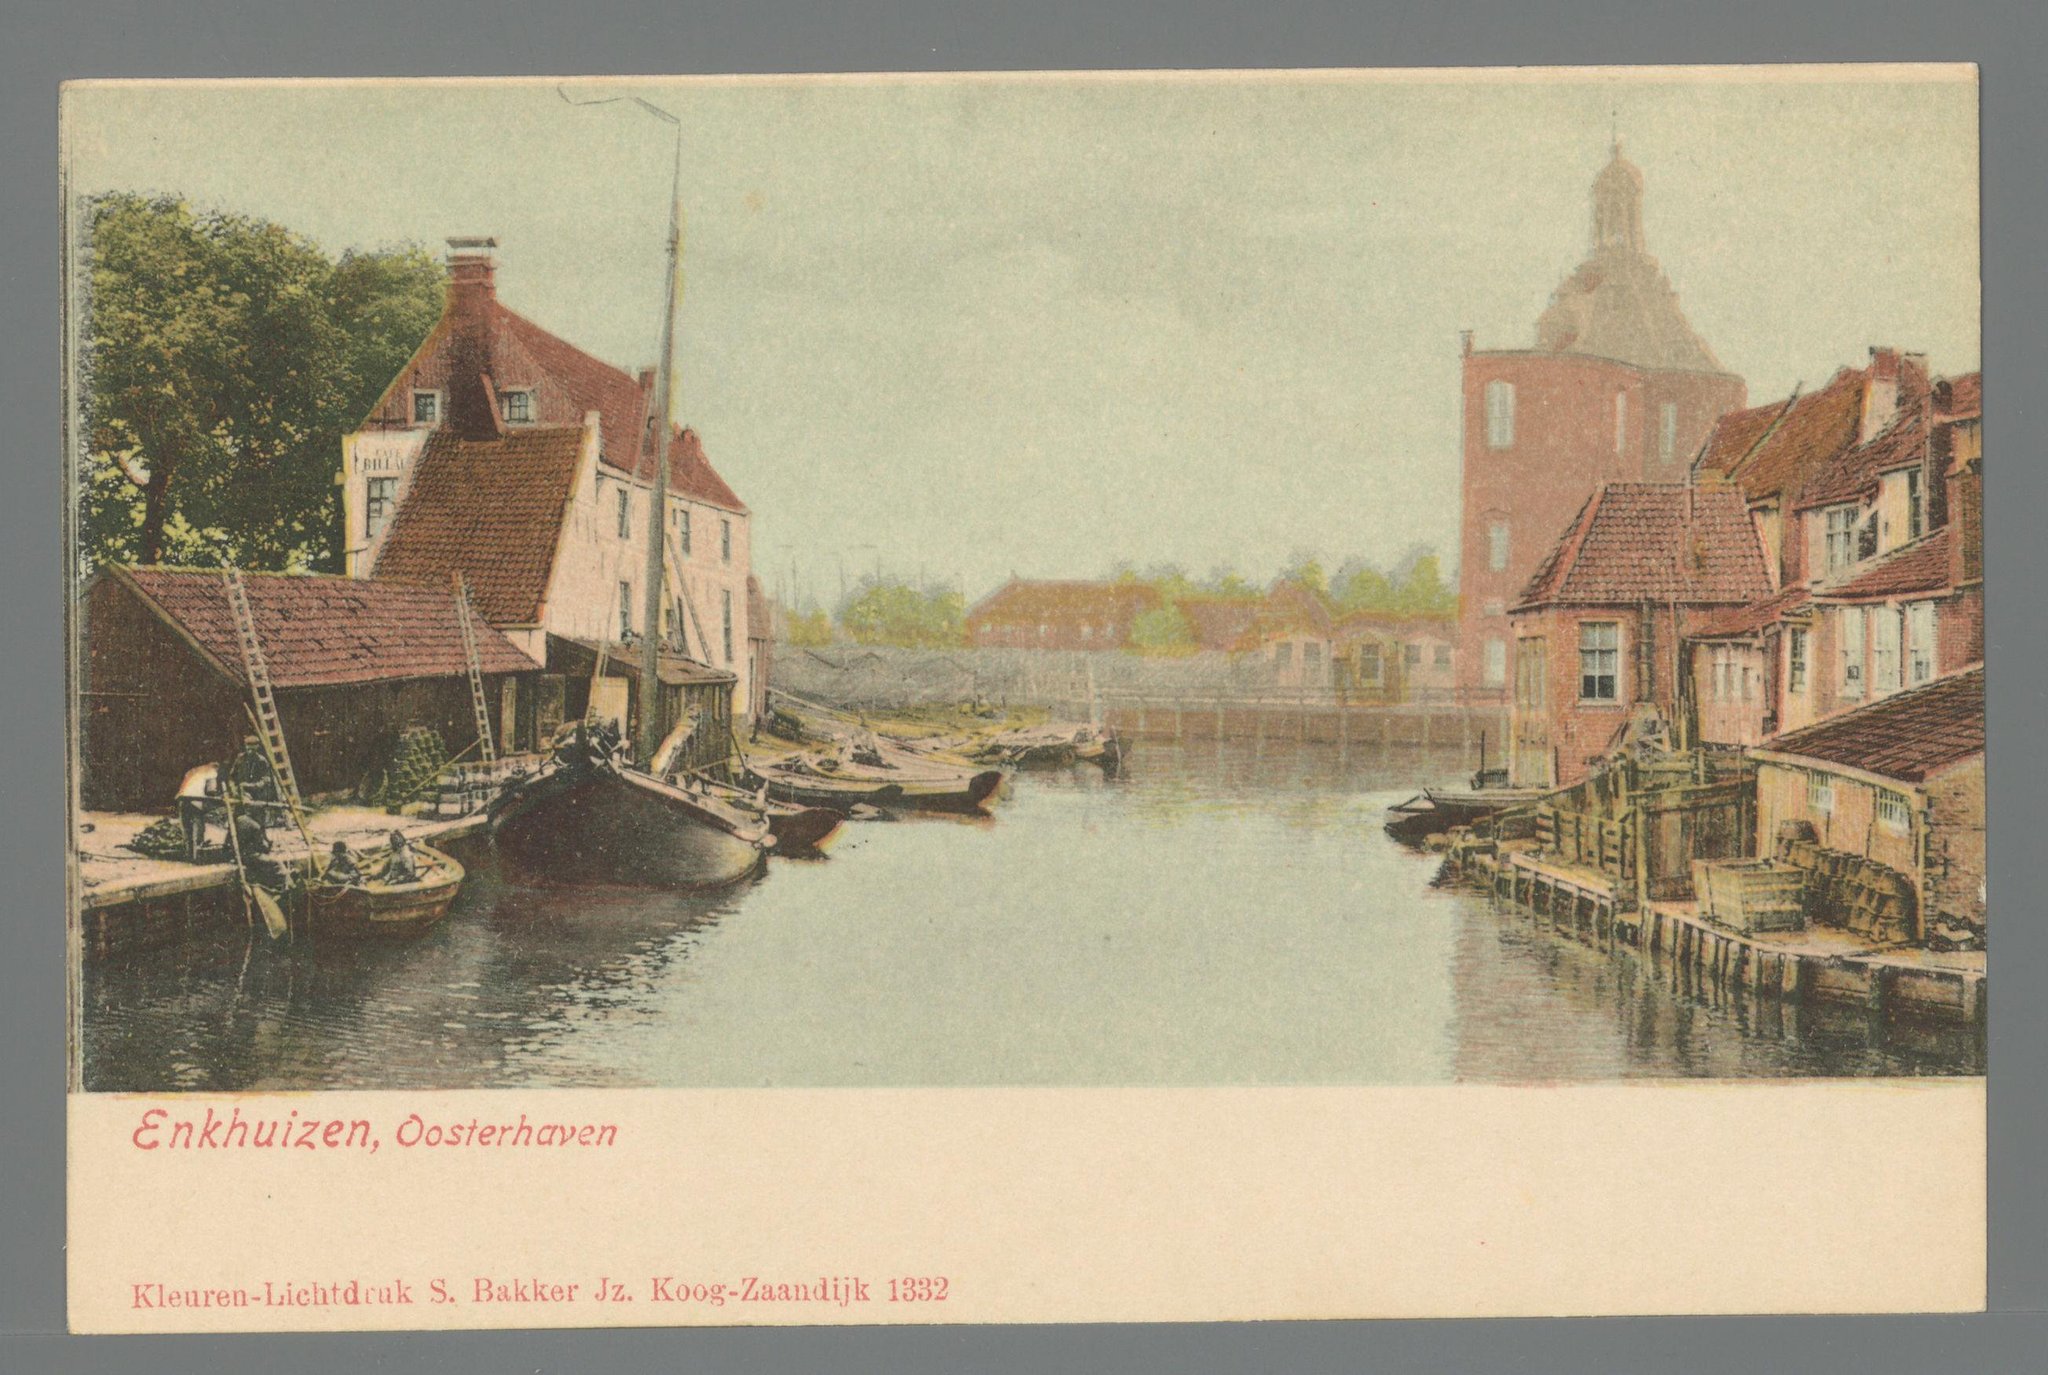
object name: ansichtkaart, prentbriefkaart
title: Enkhuizen, Oosterhaven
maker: simon bakker jz.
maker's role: printer, publisher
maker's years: 1873-1930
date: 1899-1905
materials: cardboard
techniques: photograph, lithograph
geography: koog aan de zaan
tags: city-view, and landscape with man-made constructions, canal, ships (in general), city-gate, enkhuizen